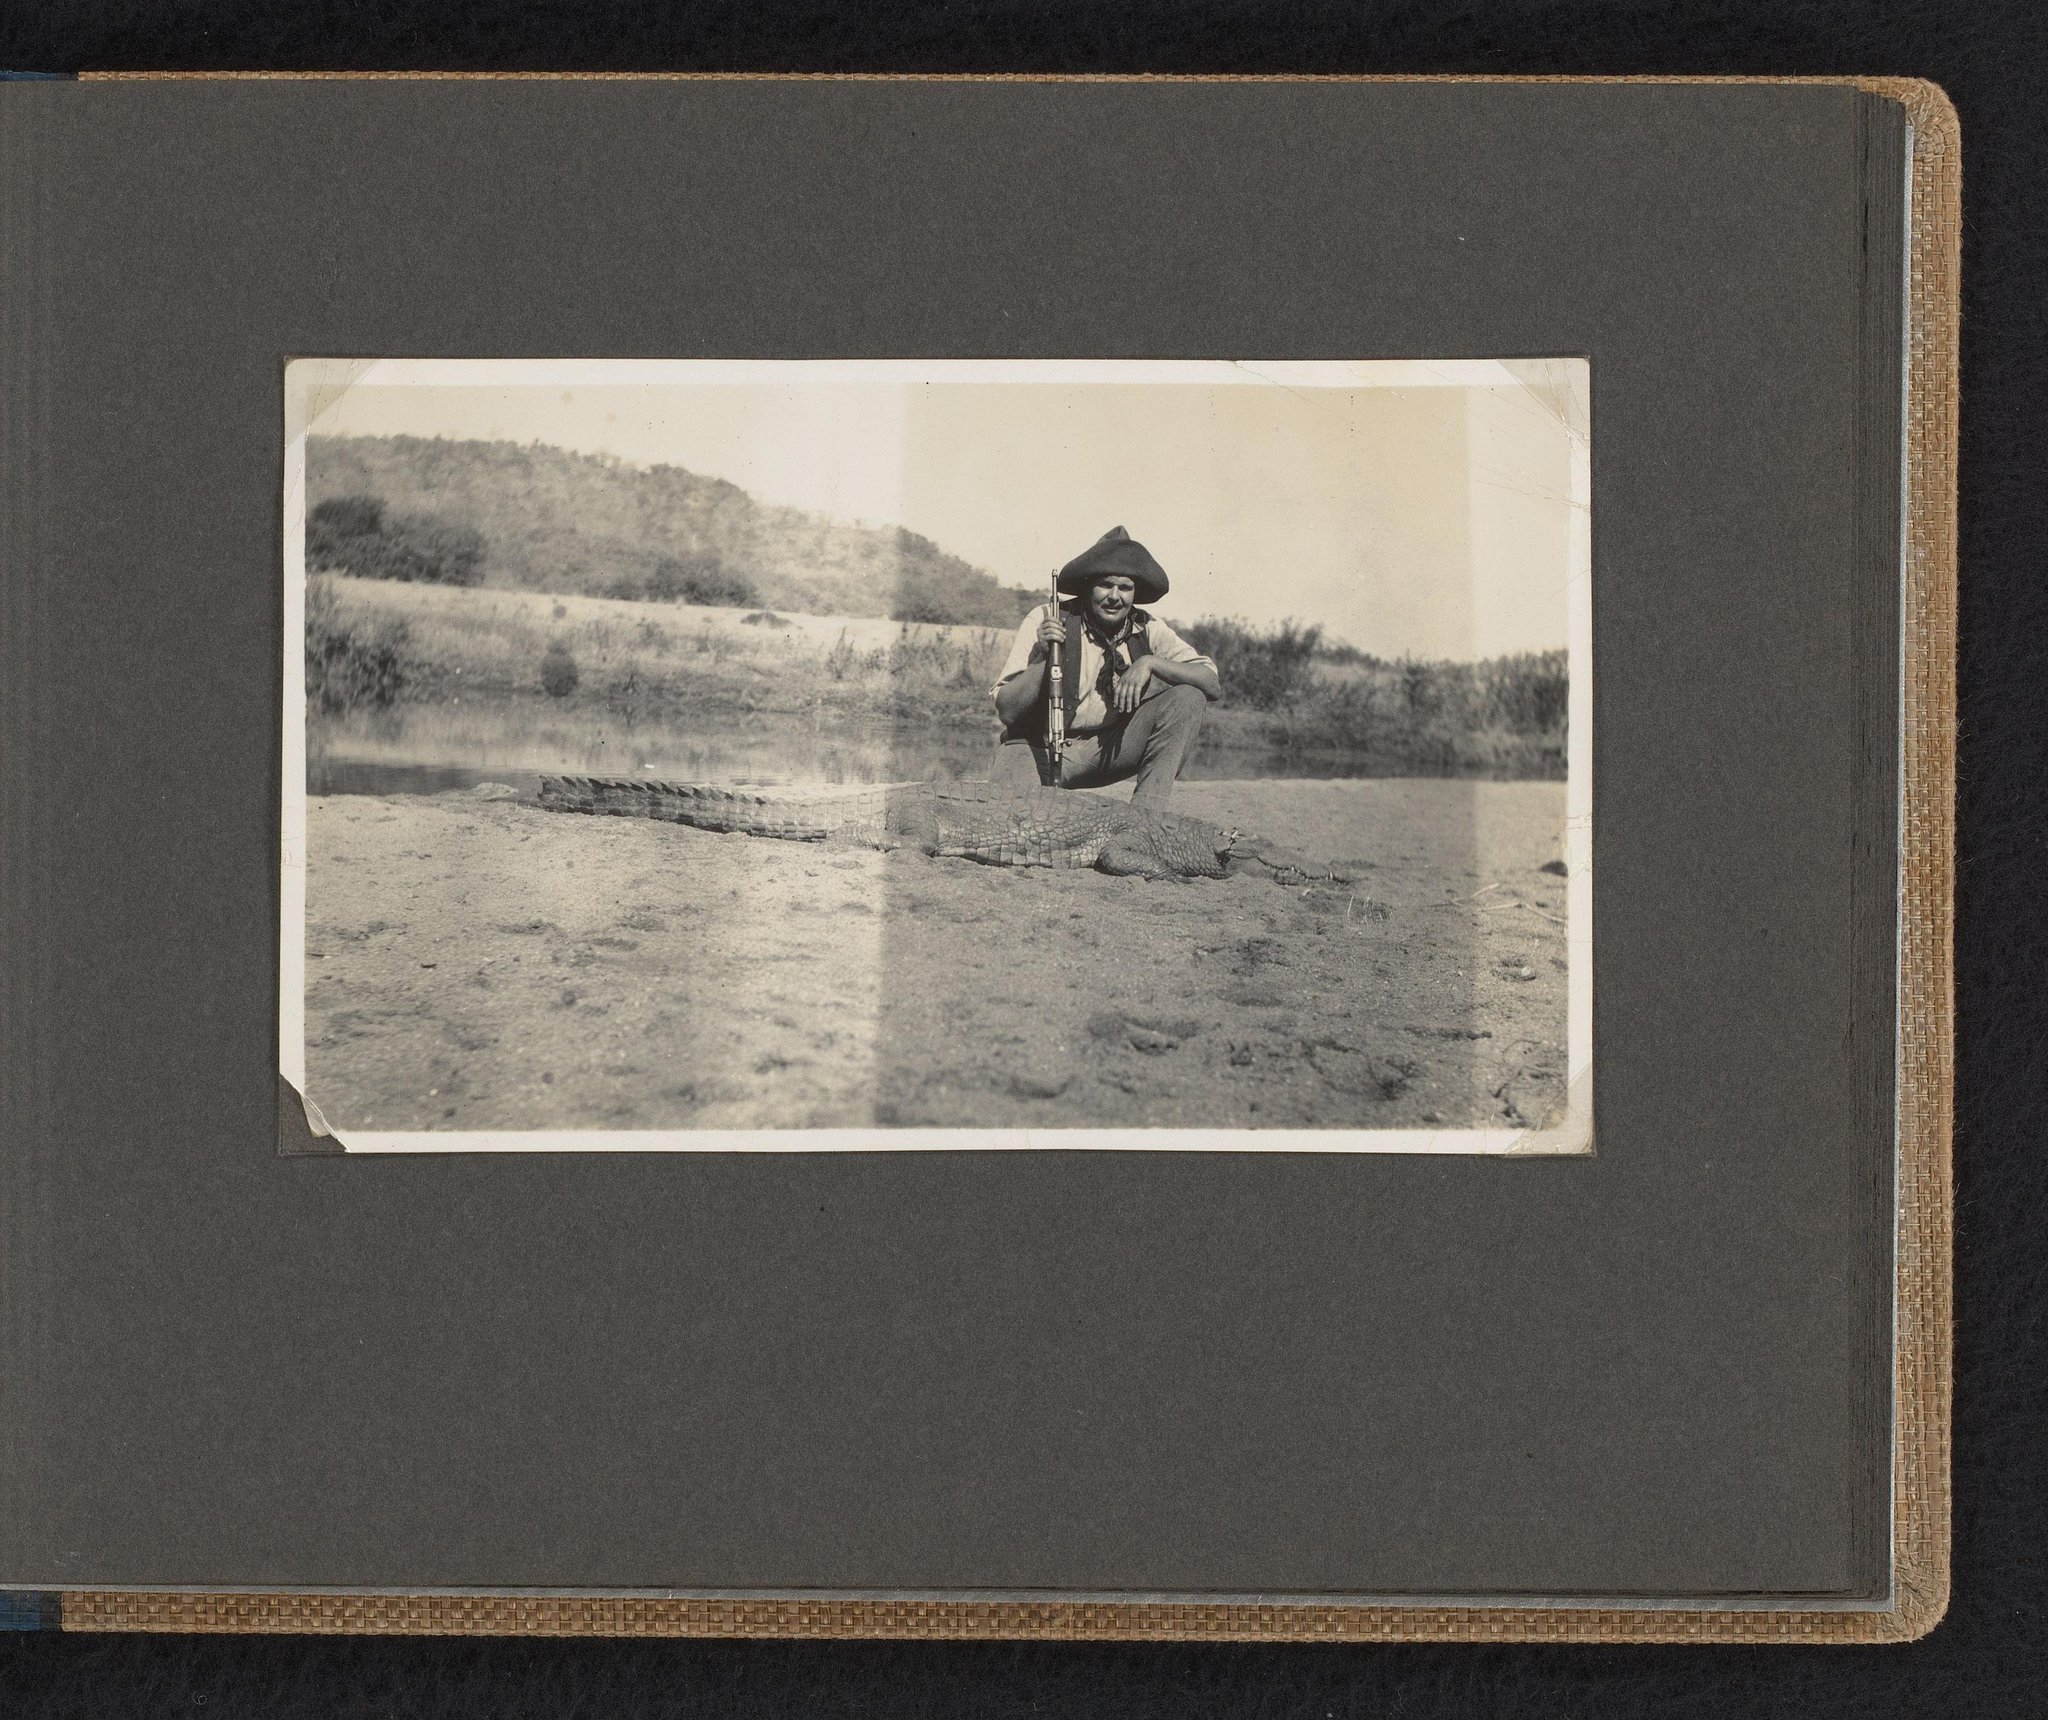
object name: photograph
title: Jager bij een geschoten krokodil, in Zuid-Afrika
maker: karel frederik van den berg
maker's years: 1873-1948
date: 1920-1930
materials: paper, cardboard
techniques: gelatin silver print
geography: south africa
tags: hunter displaying or presenting the spoils of the hunt, crocodiles